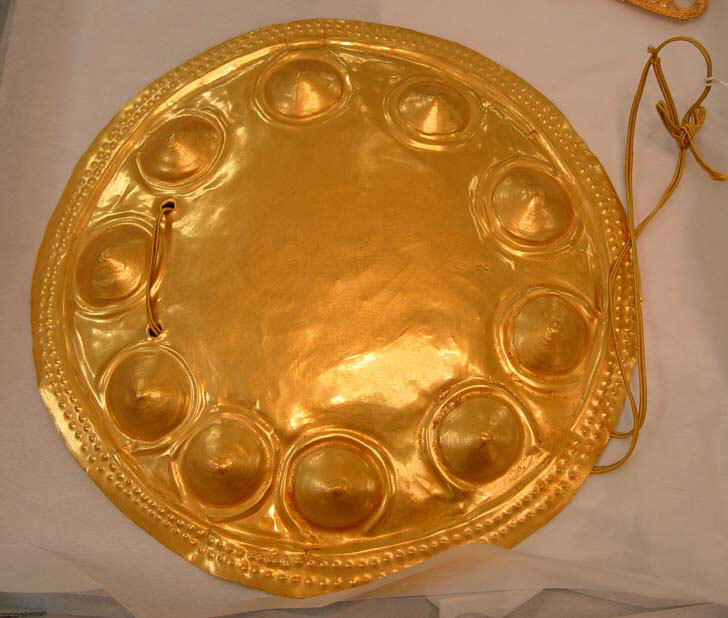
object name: pectoral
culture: indigenous american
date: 1001-1600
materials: gold